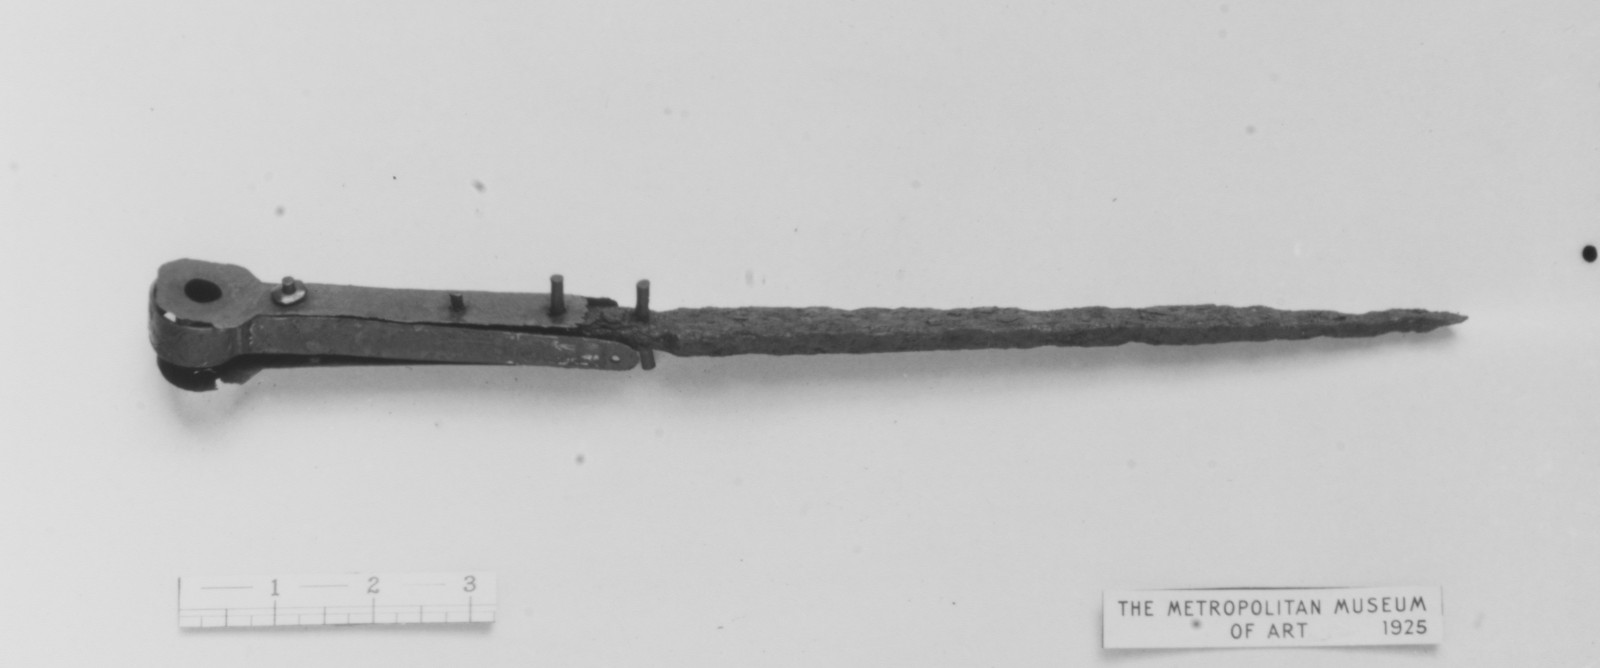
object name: eared dagger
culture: british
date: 1350-1400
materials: iron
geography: england